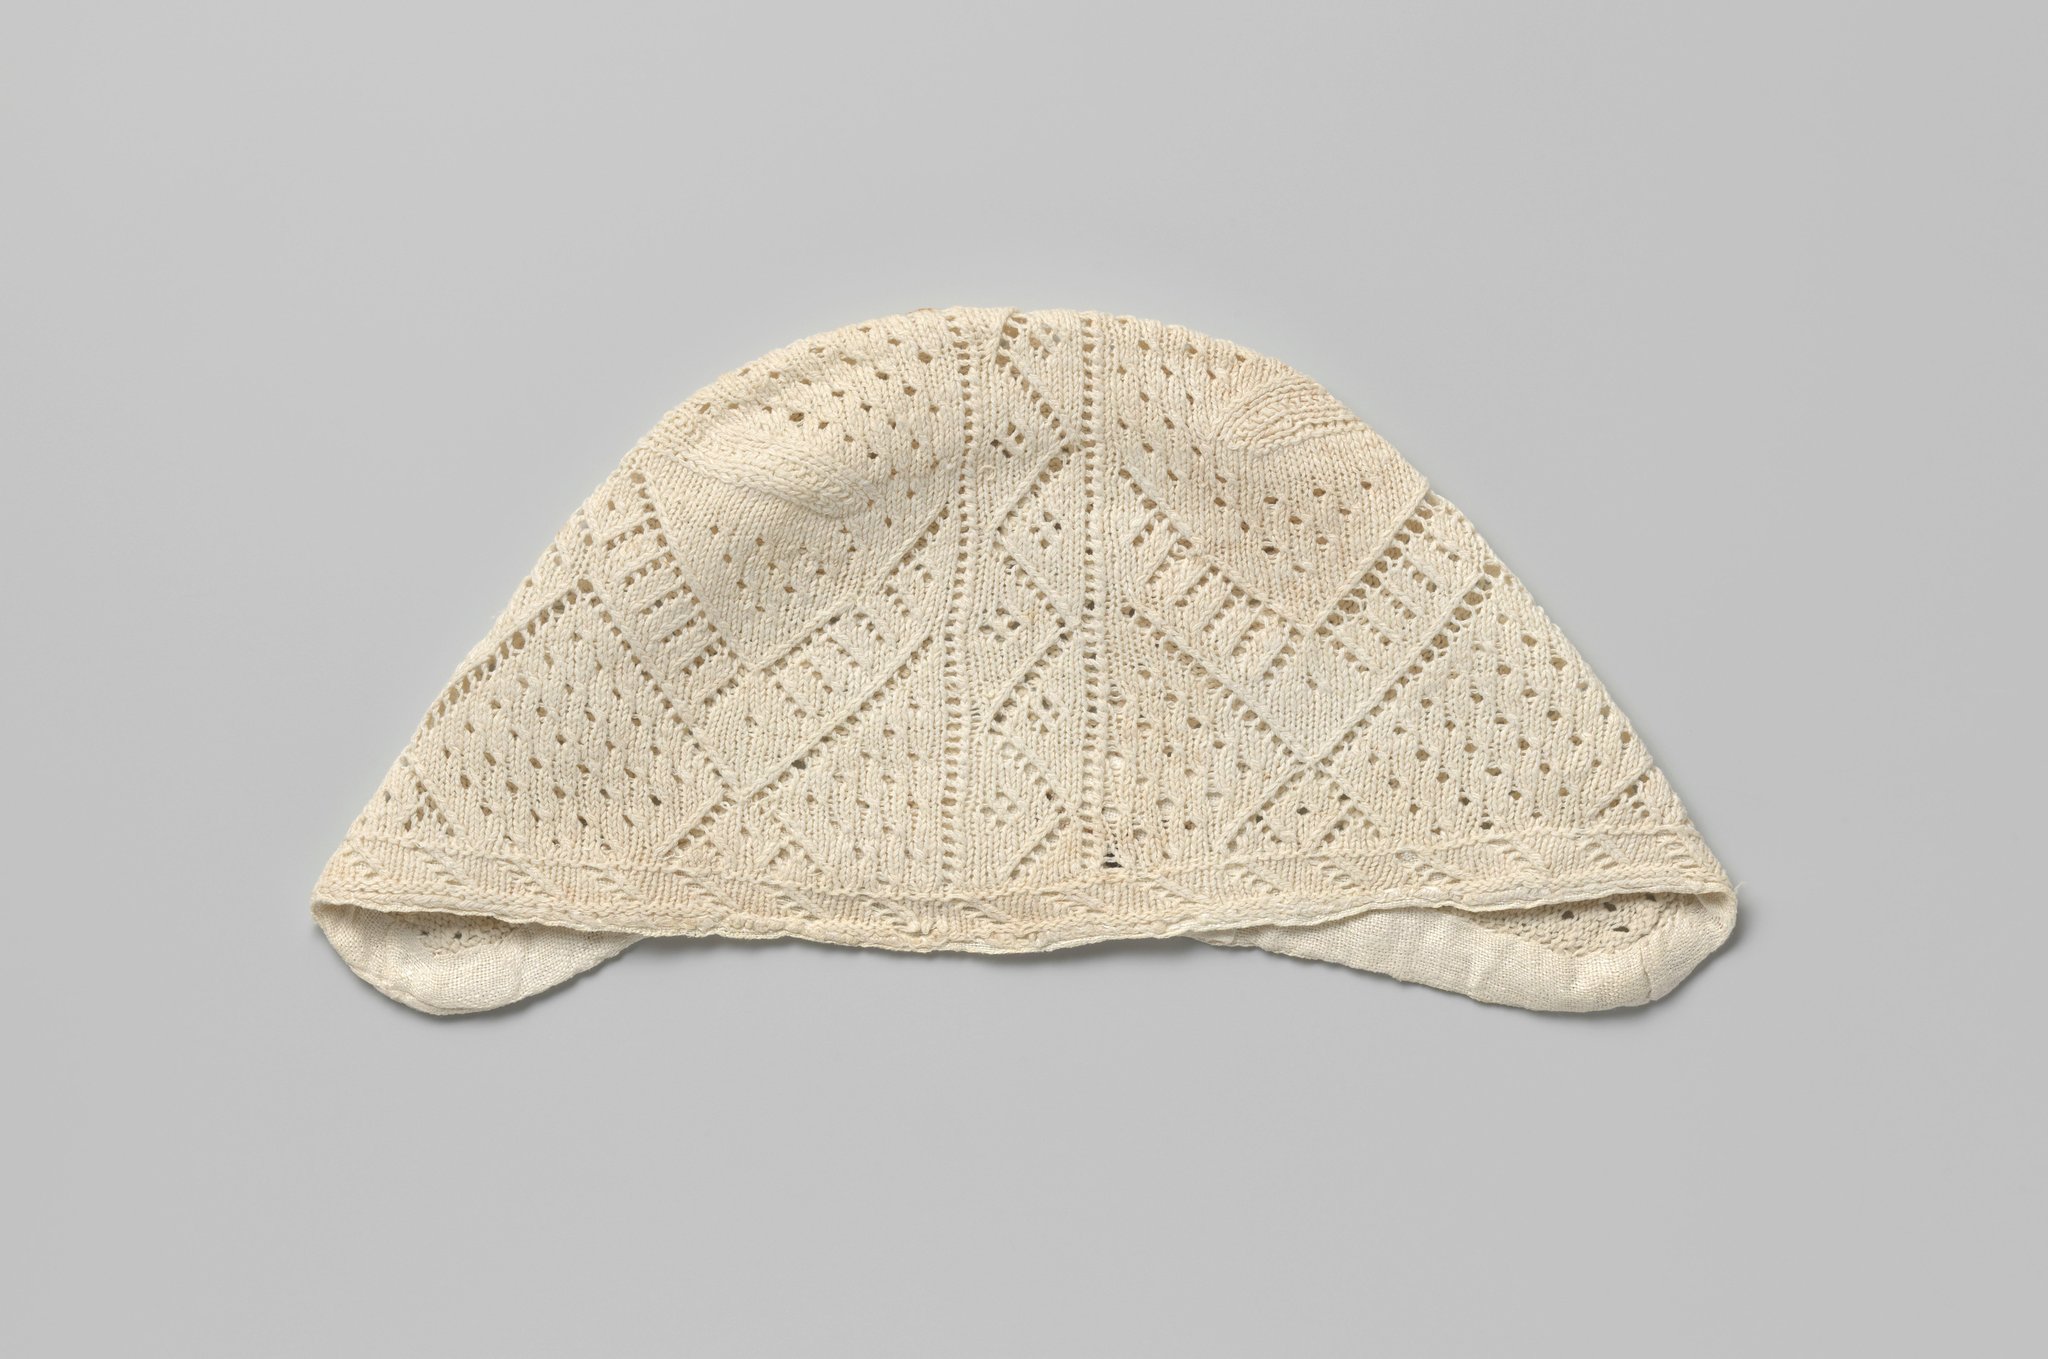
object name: womenswear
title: Gebreide muts van wit katoen met open rondjes, zigzagranden en over het midden een opengewerkte rand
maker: Anonymous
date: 1800-1900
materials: cotton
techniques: embroidery, knitting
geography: europe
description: Gebreide muts van wit katoen met open rondjes, zigzagranden en over het midden een opengewerkte rand.